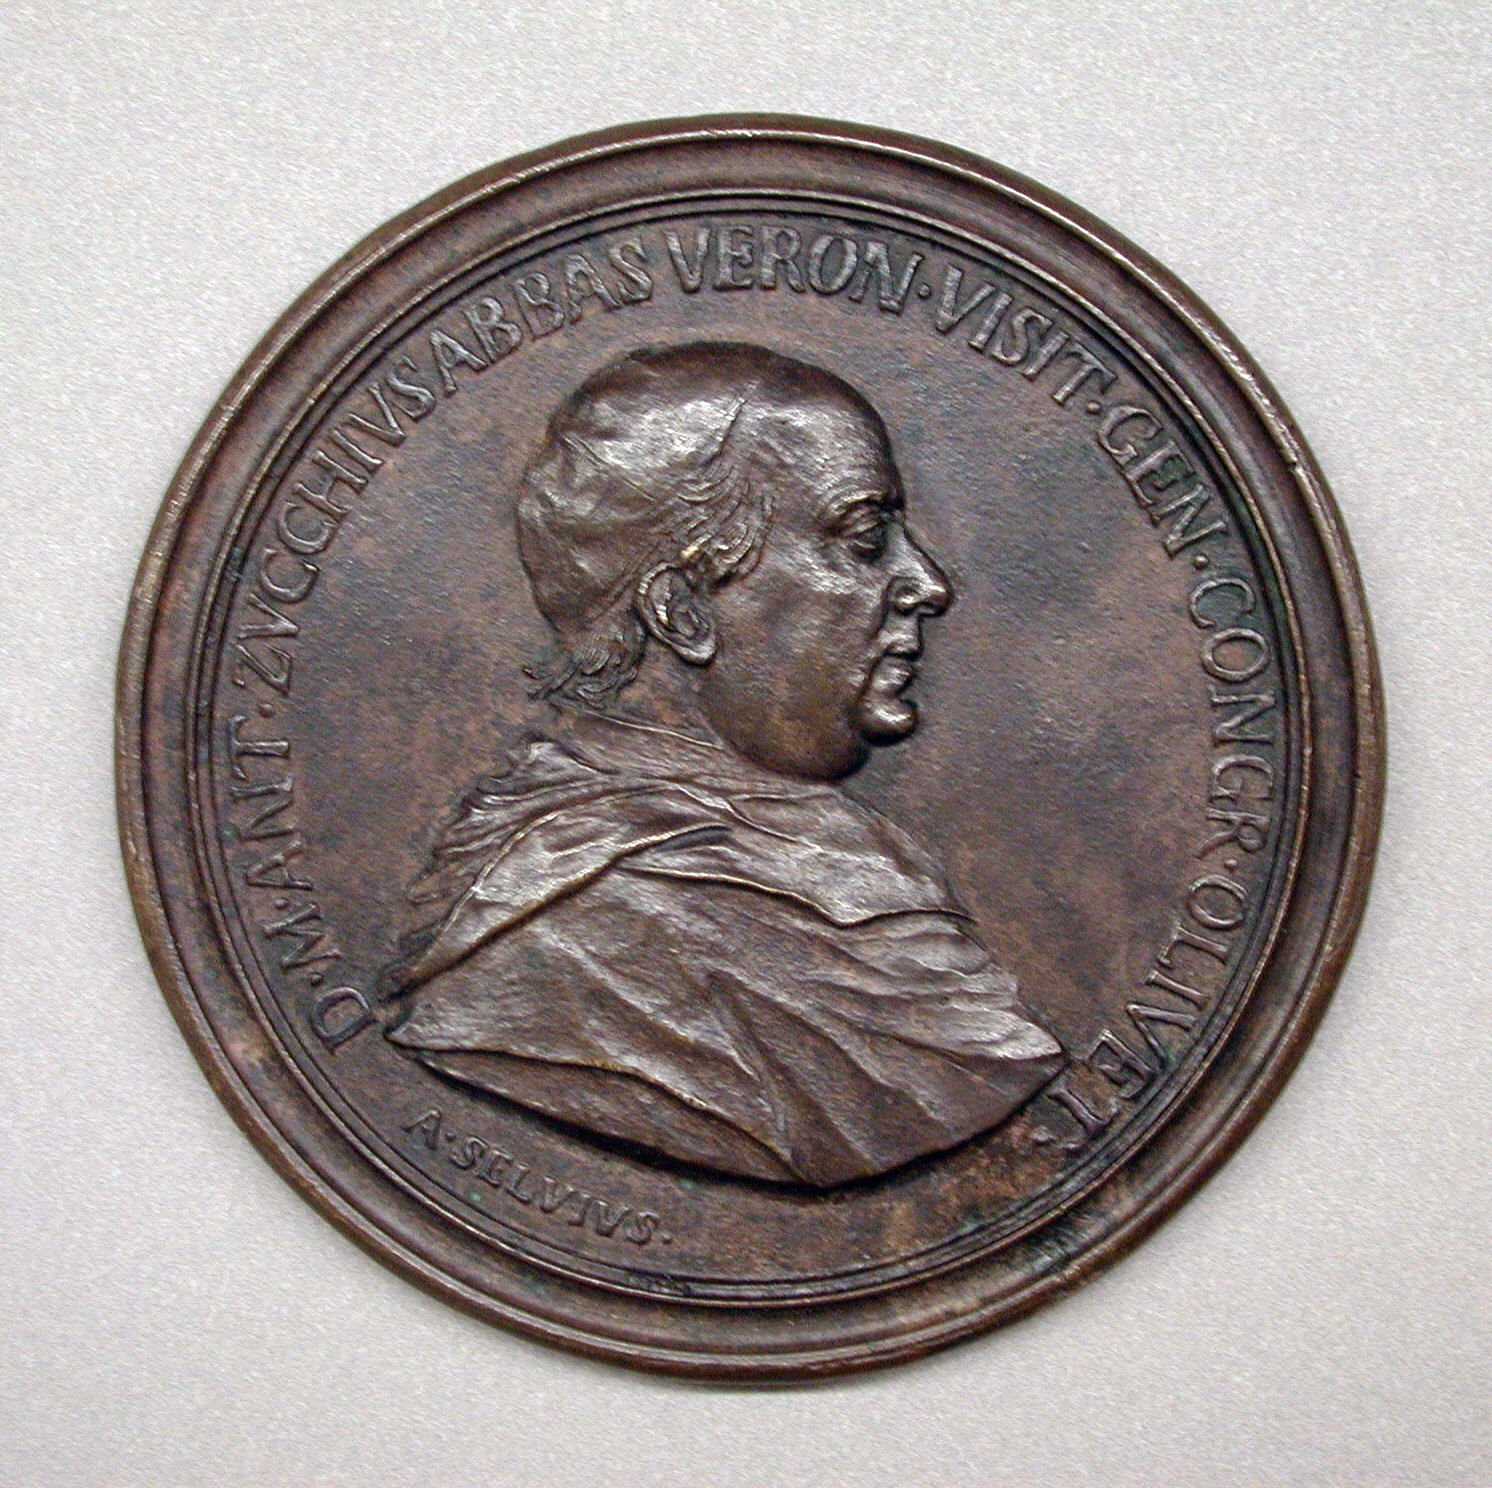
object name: medal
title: Marco Antonio Zucchi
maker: antonio francesco selvi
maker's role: artist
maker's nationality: italian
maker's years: 1679-1755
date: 1750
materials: bronze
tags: men,profiles